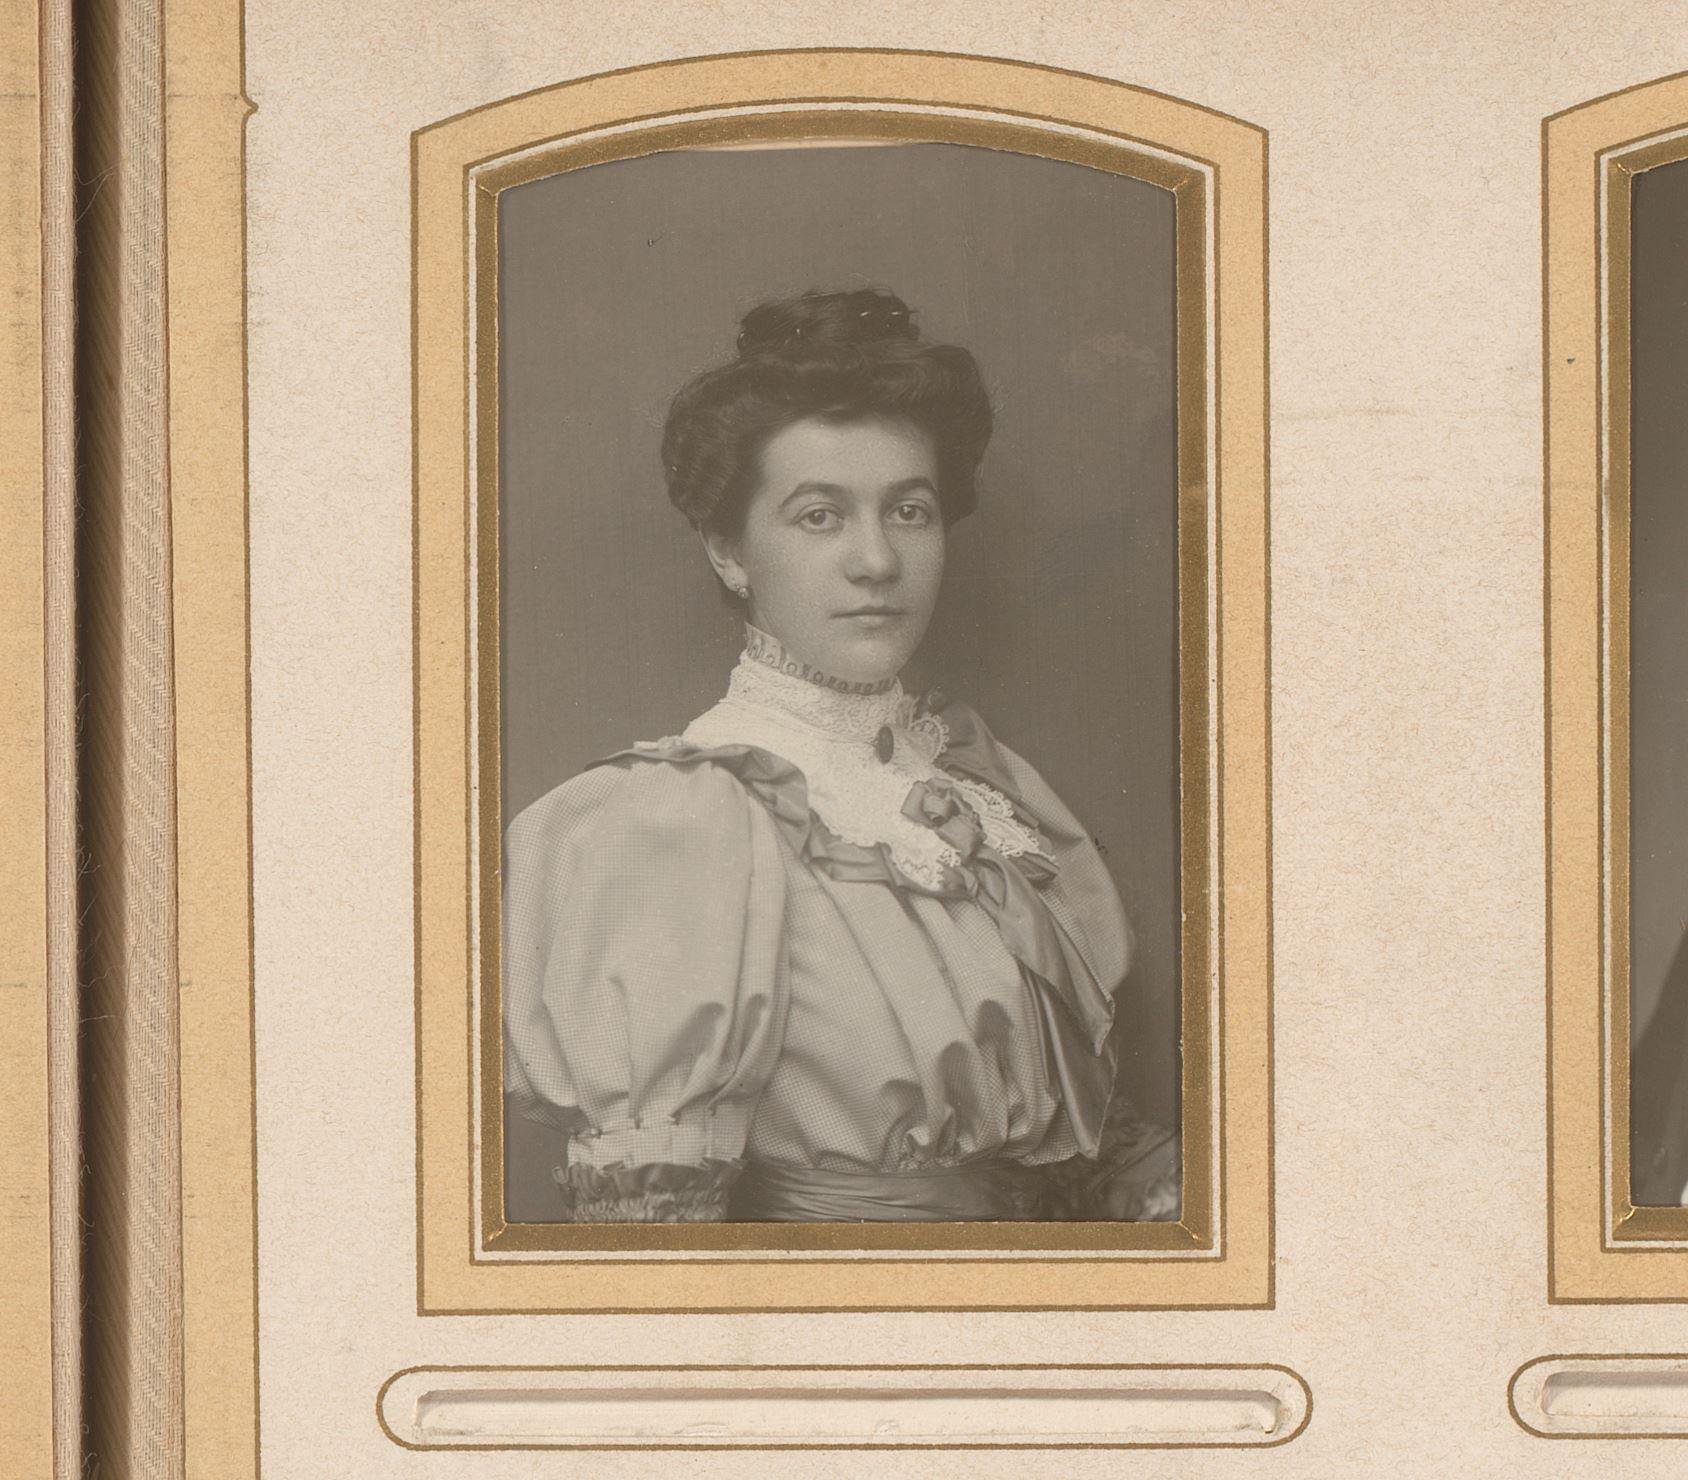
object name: photograph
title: Portret van een vrouw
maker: Anonymous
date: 1880-1920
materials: cardboard, photographic support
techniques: gelatin silver print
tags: adult woman, historical persons